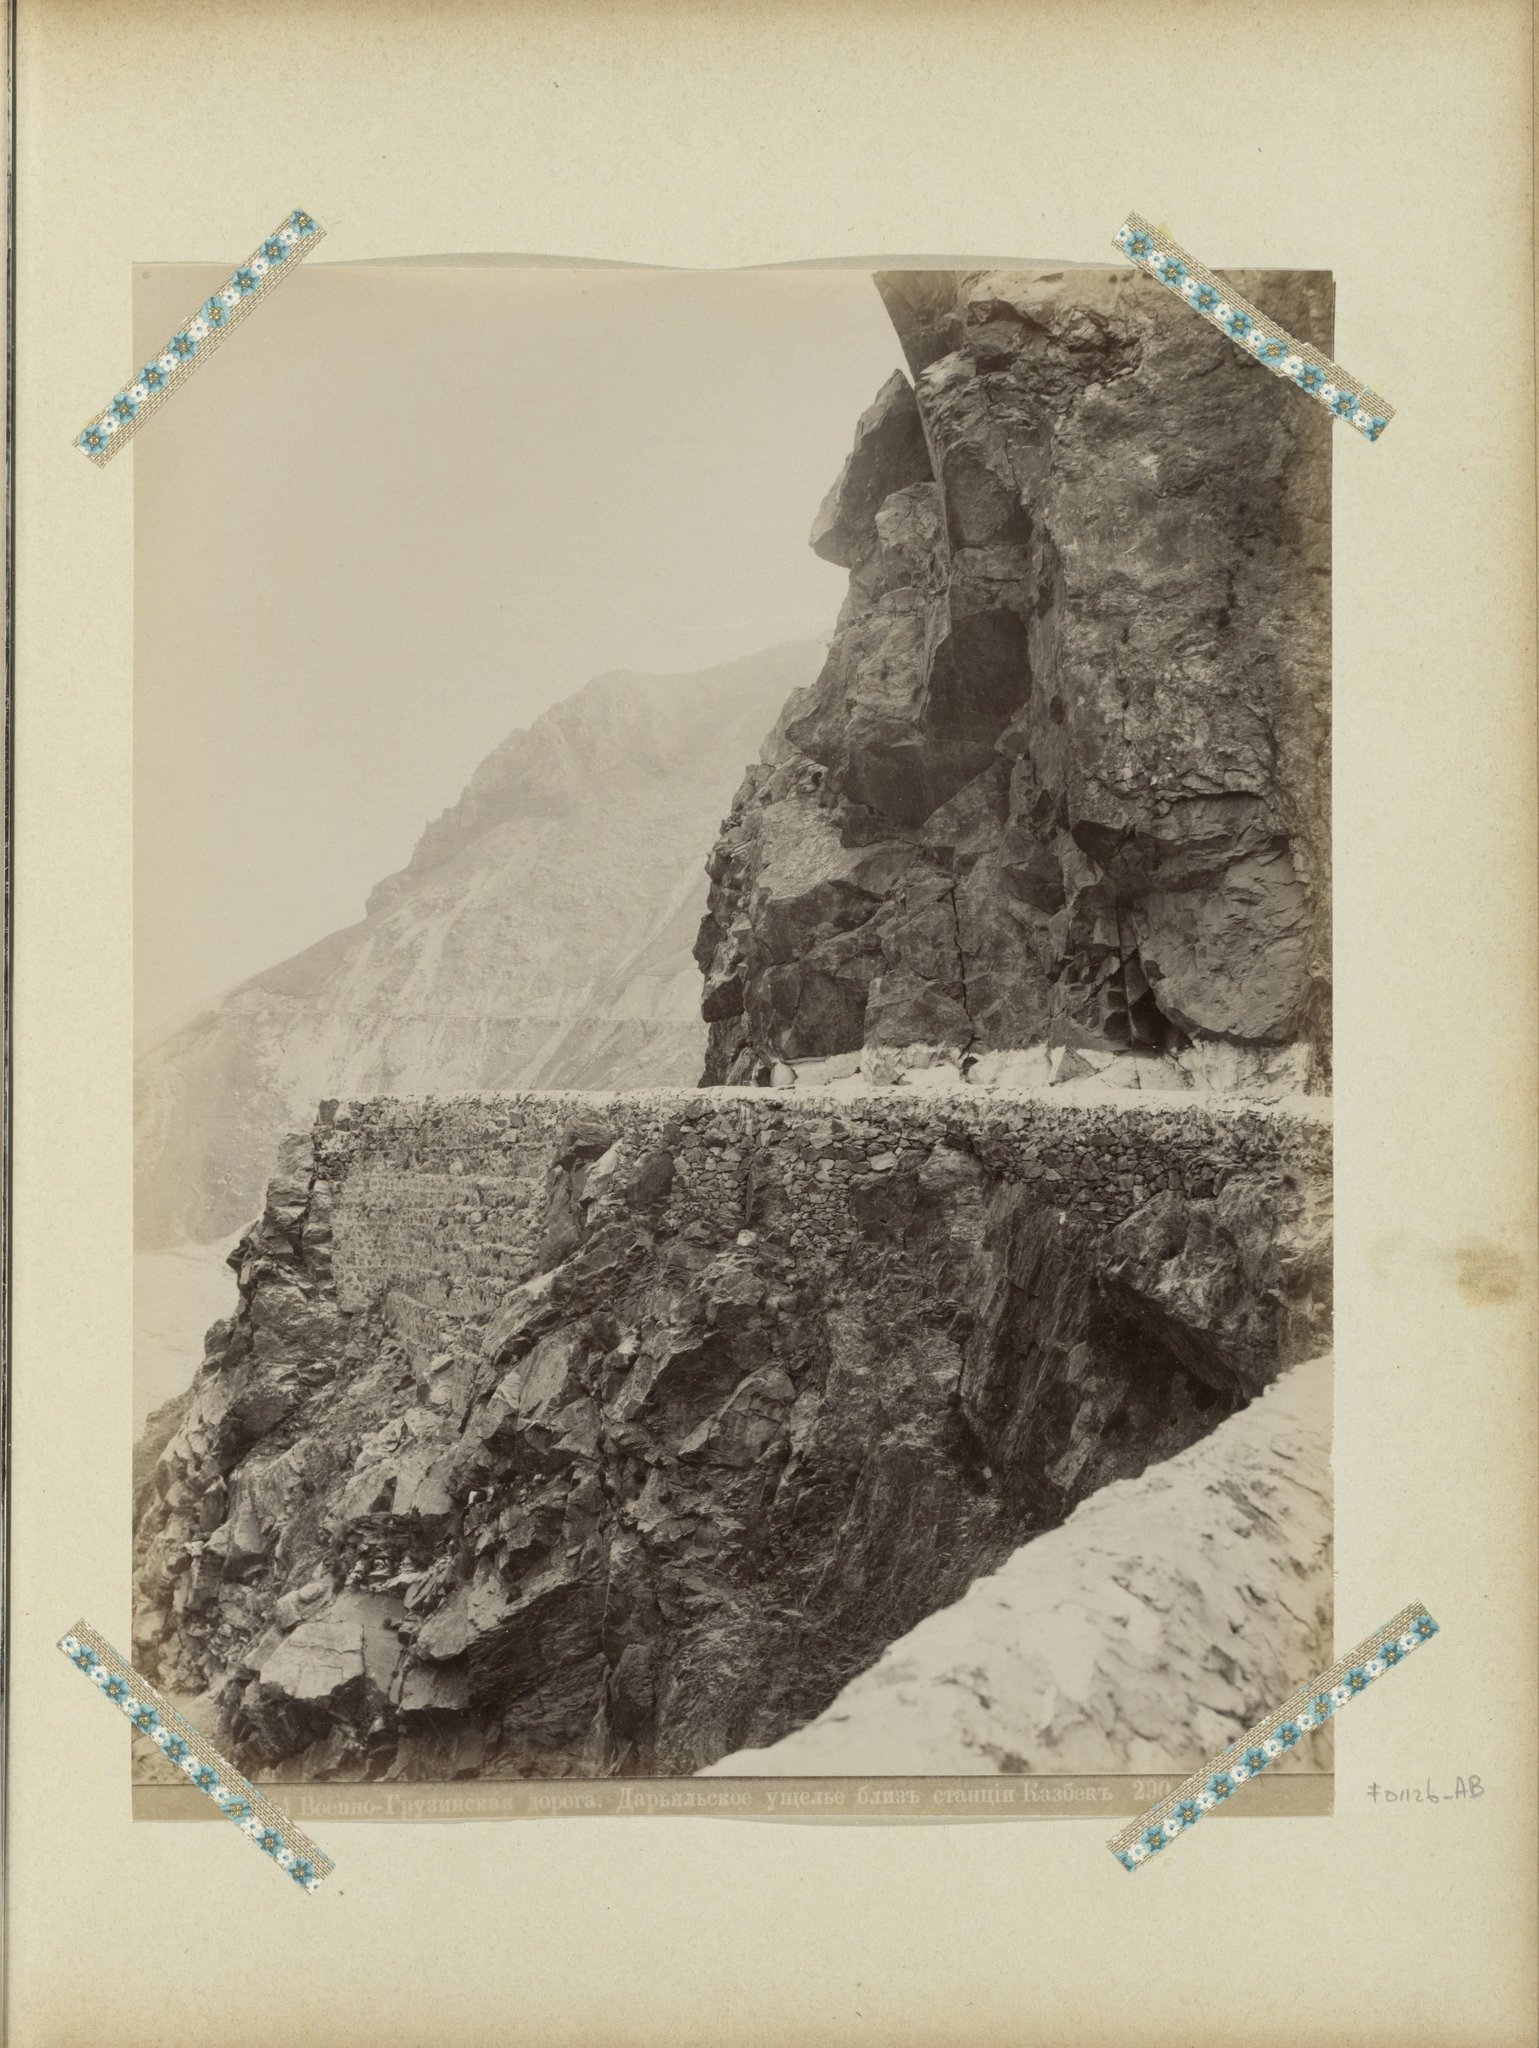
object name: photograph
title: Berglandschap met militaire weg in Georgië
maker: dimitri ivanovitch ermakov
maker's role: fotograaf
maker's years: 1845-1916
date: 1890-1900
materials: photographic support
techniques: albumen print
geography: georgia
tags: road, path, mountains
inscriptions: number: ‘290’, number: ‘8664’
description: Onderdeel van Fotoalbum met opnames van bezienswaardigheden in Georgië, Sint-Petersburg en Moskou.